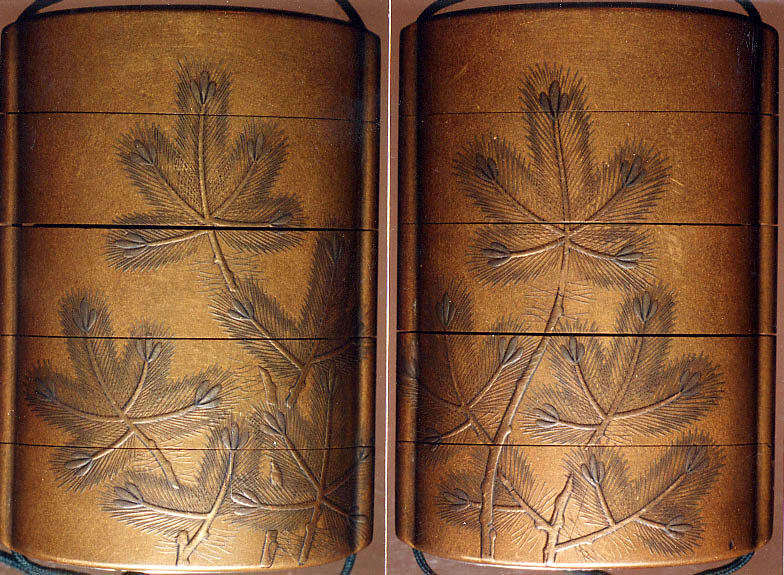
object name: inrō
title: Case (Inrō) with Design of Young Pine Trees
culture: japanese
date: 1701-1900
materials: gold, lacquer, silver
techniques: fundame, hiramakie, maki-e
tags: trees